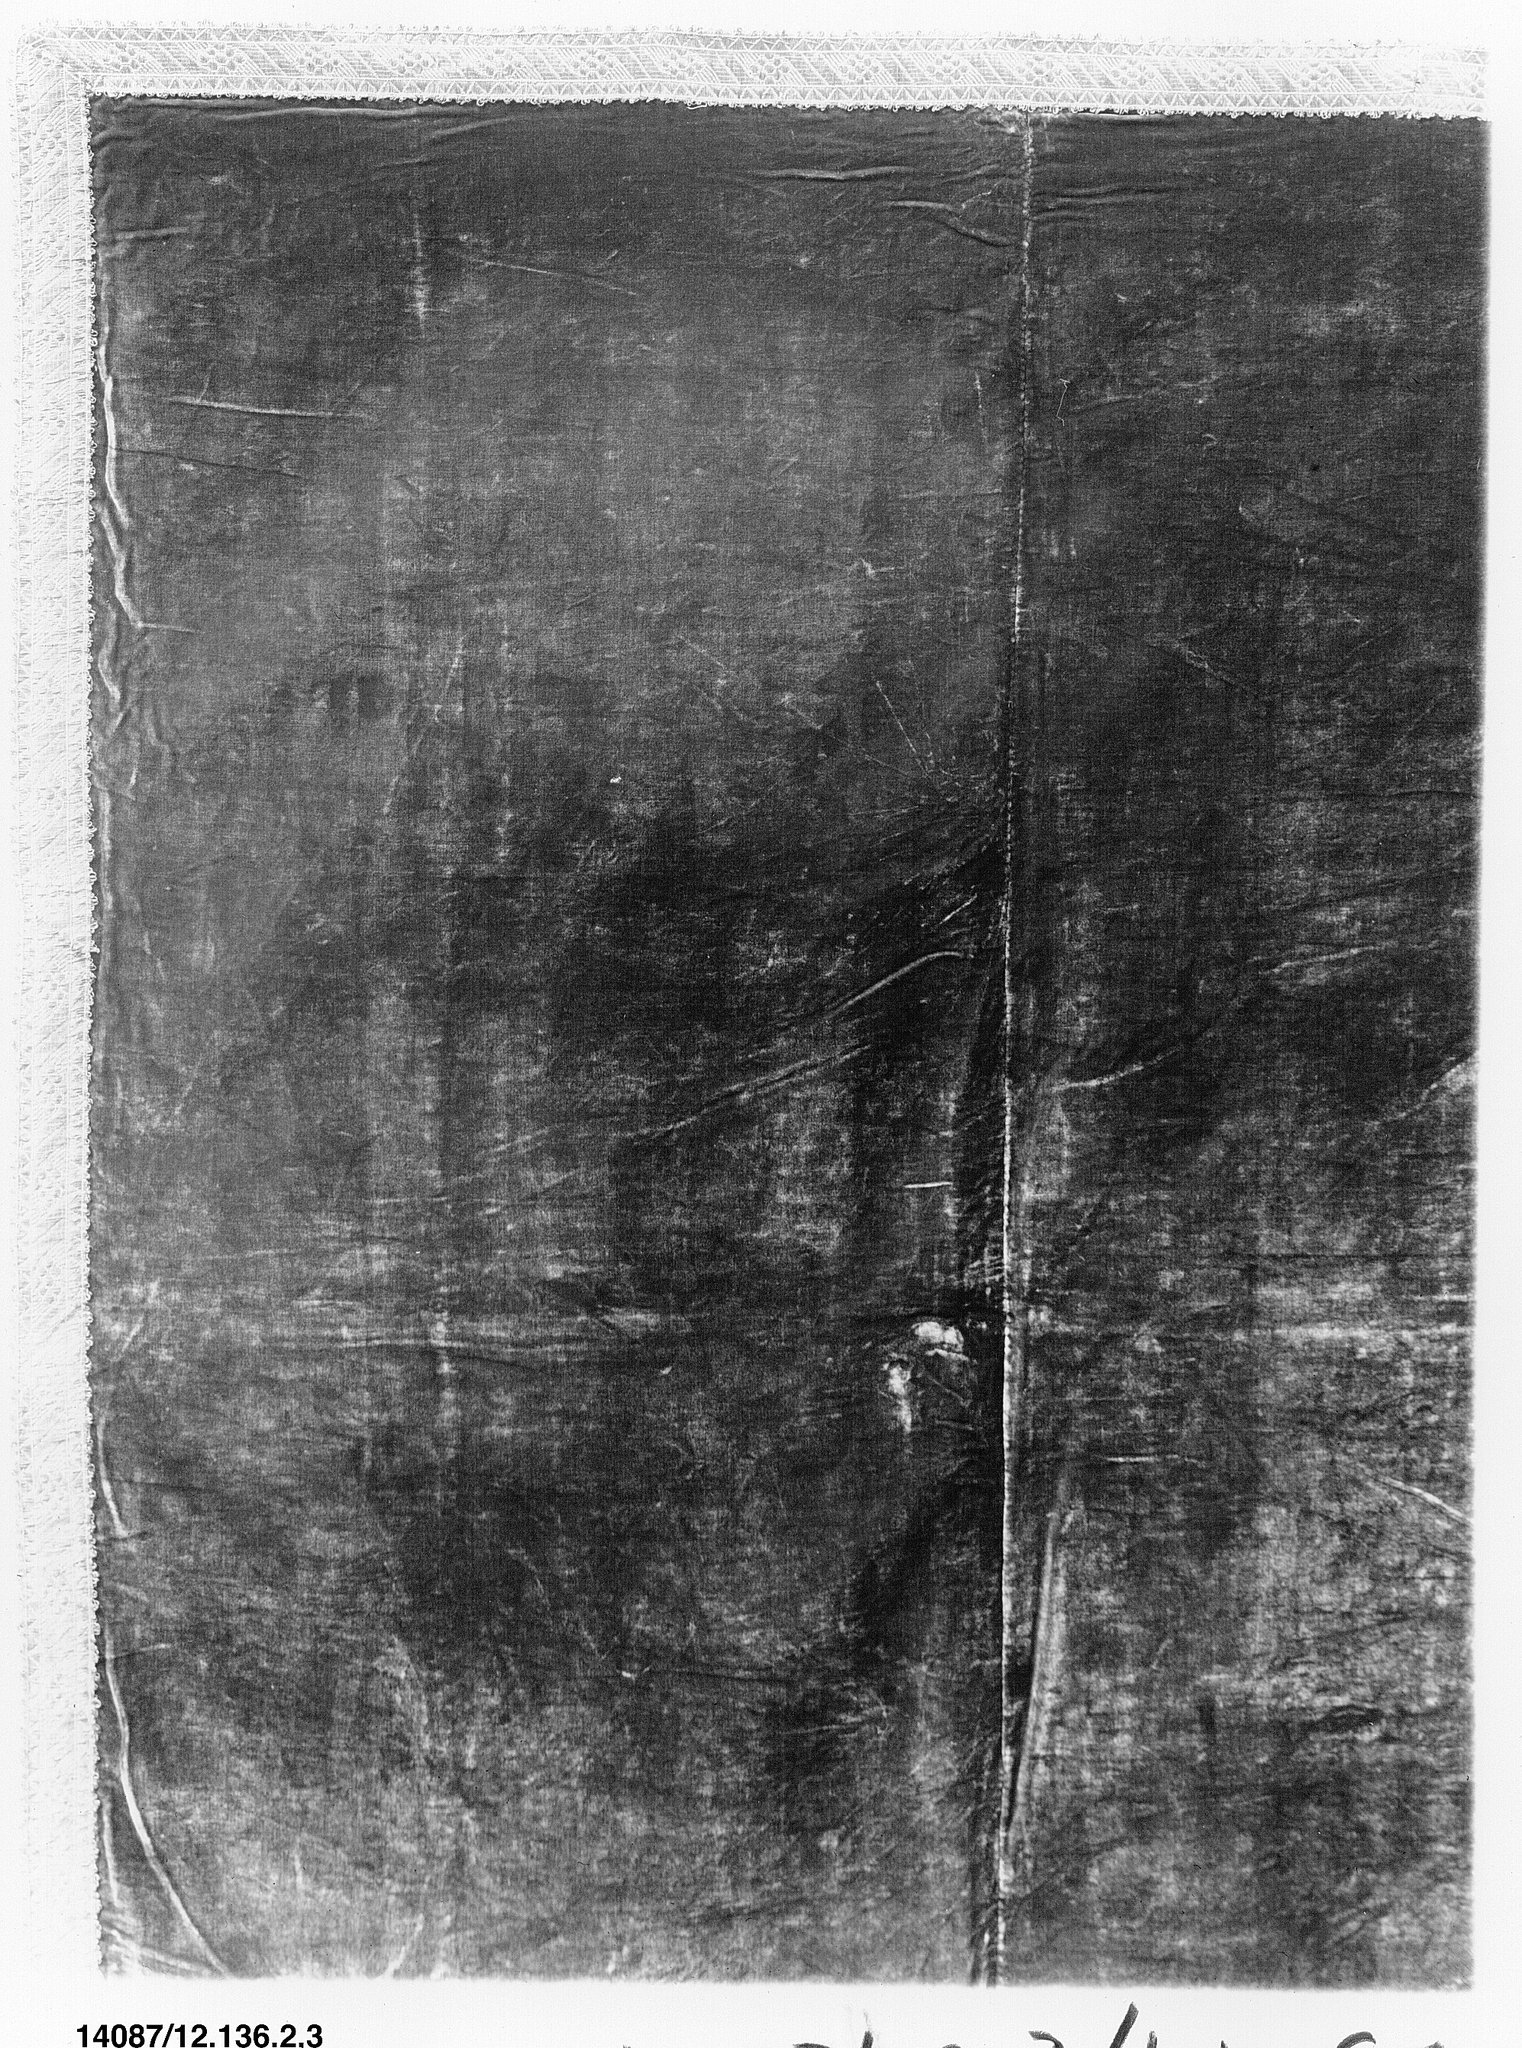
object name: piece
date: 1501-1700